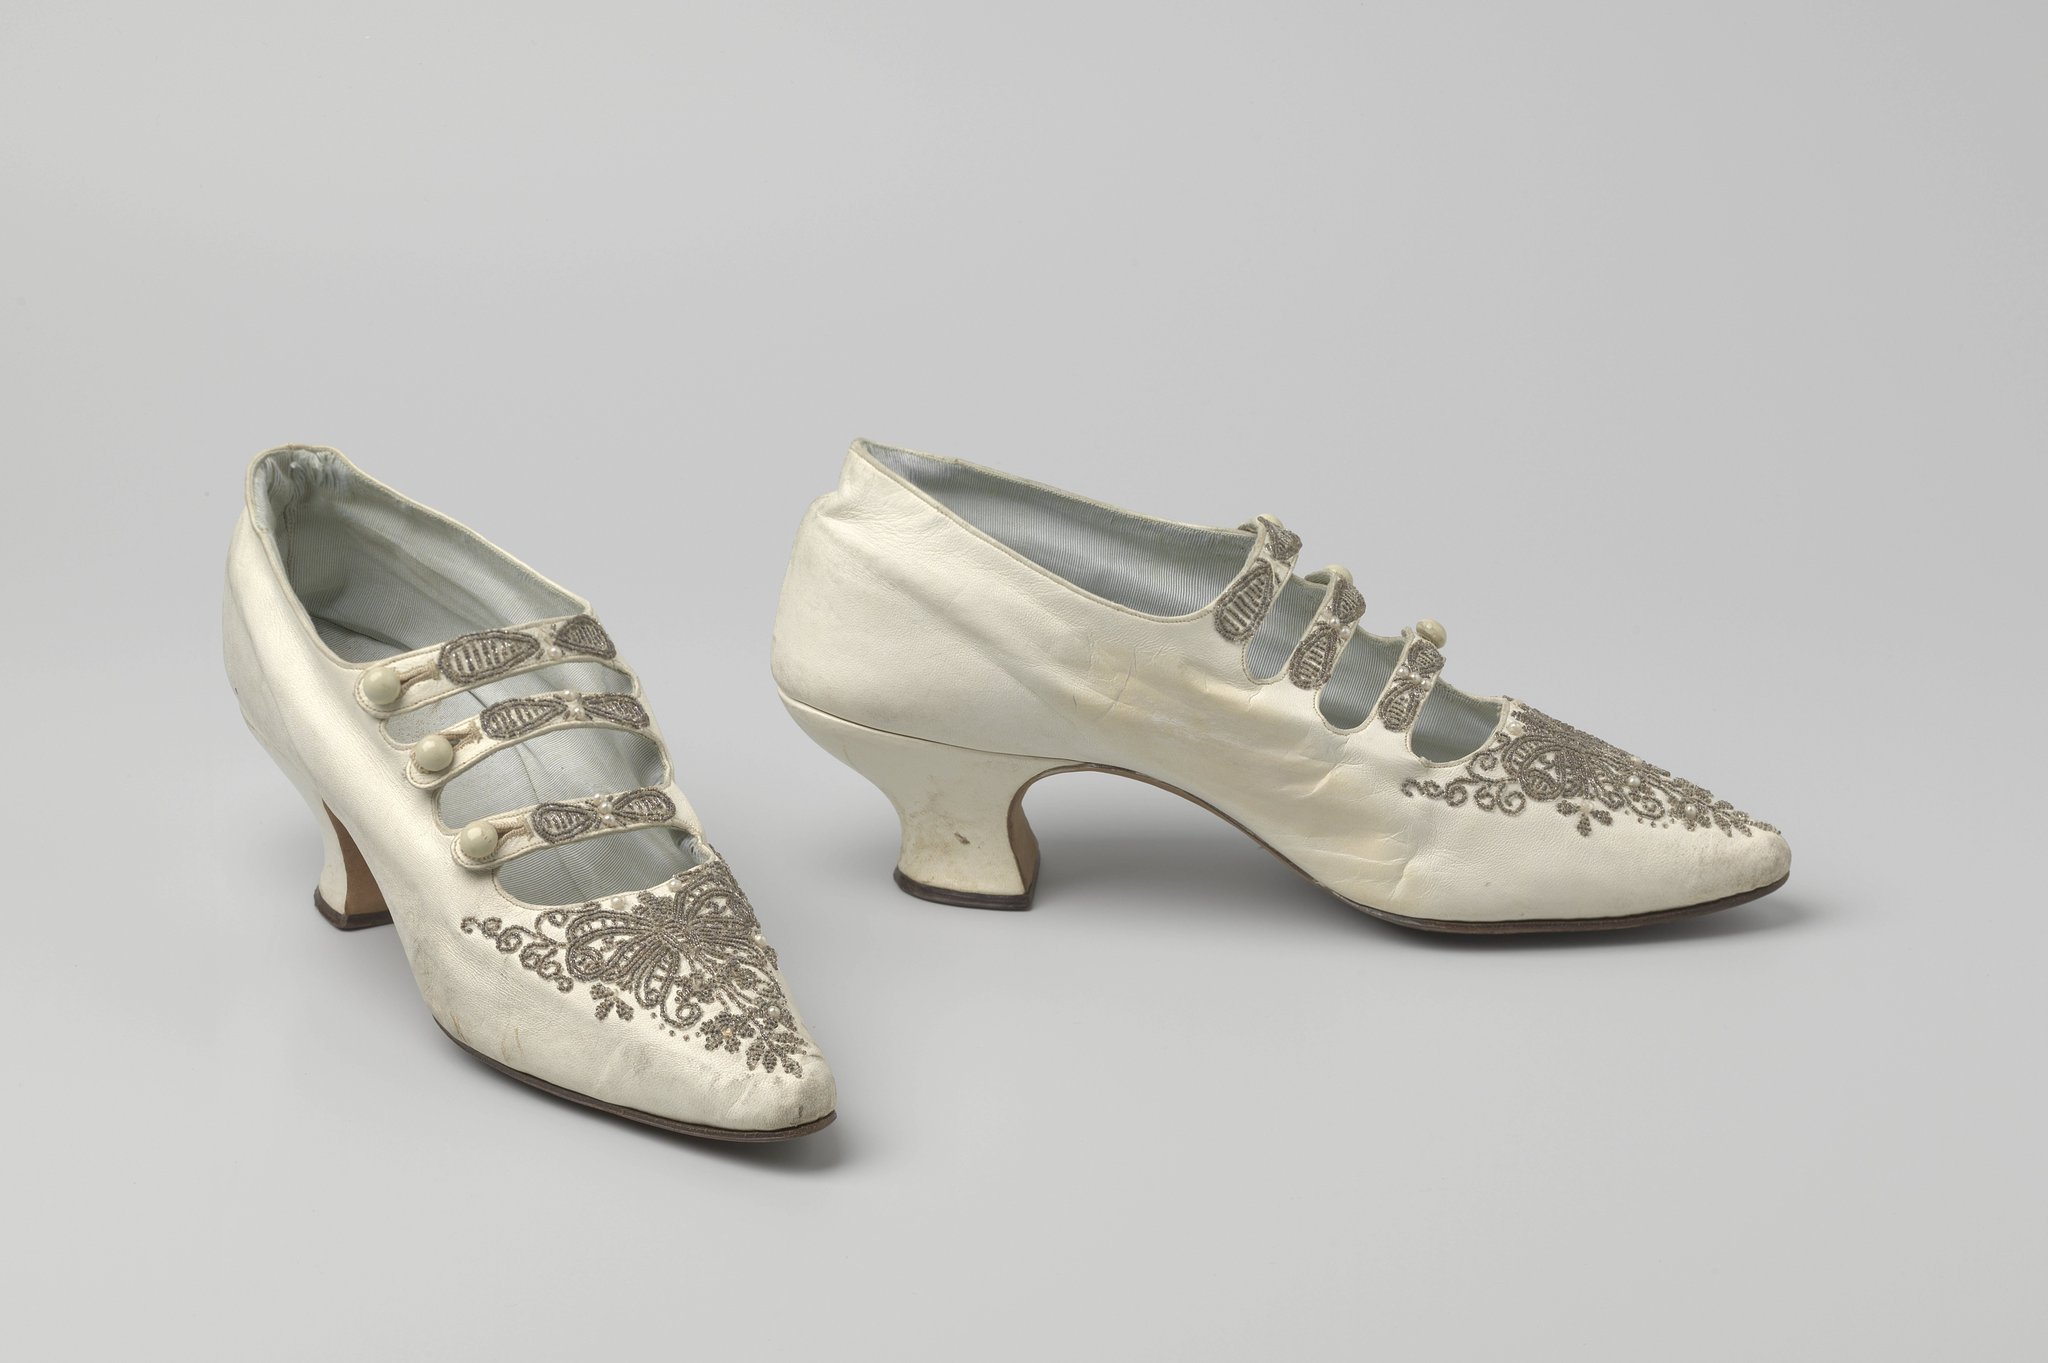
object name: womenswear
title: Bandschoen van wit glacéleer met drie riempjes met witte bolle knoop, versierd met witte glaskralen en parels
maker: Anonymous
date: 1895-1905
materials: glass, silk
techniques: rib binding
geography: brussels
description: Bandschoen van wit glacéleer met witte glaskraaltjes en pareltjes. Riempjesschoenen met drie riempjes met witte bolle knoopjes. Zeer spitse neus, lage pompadour hakjes. Voering van lichtblauw ripszijde.